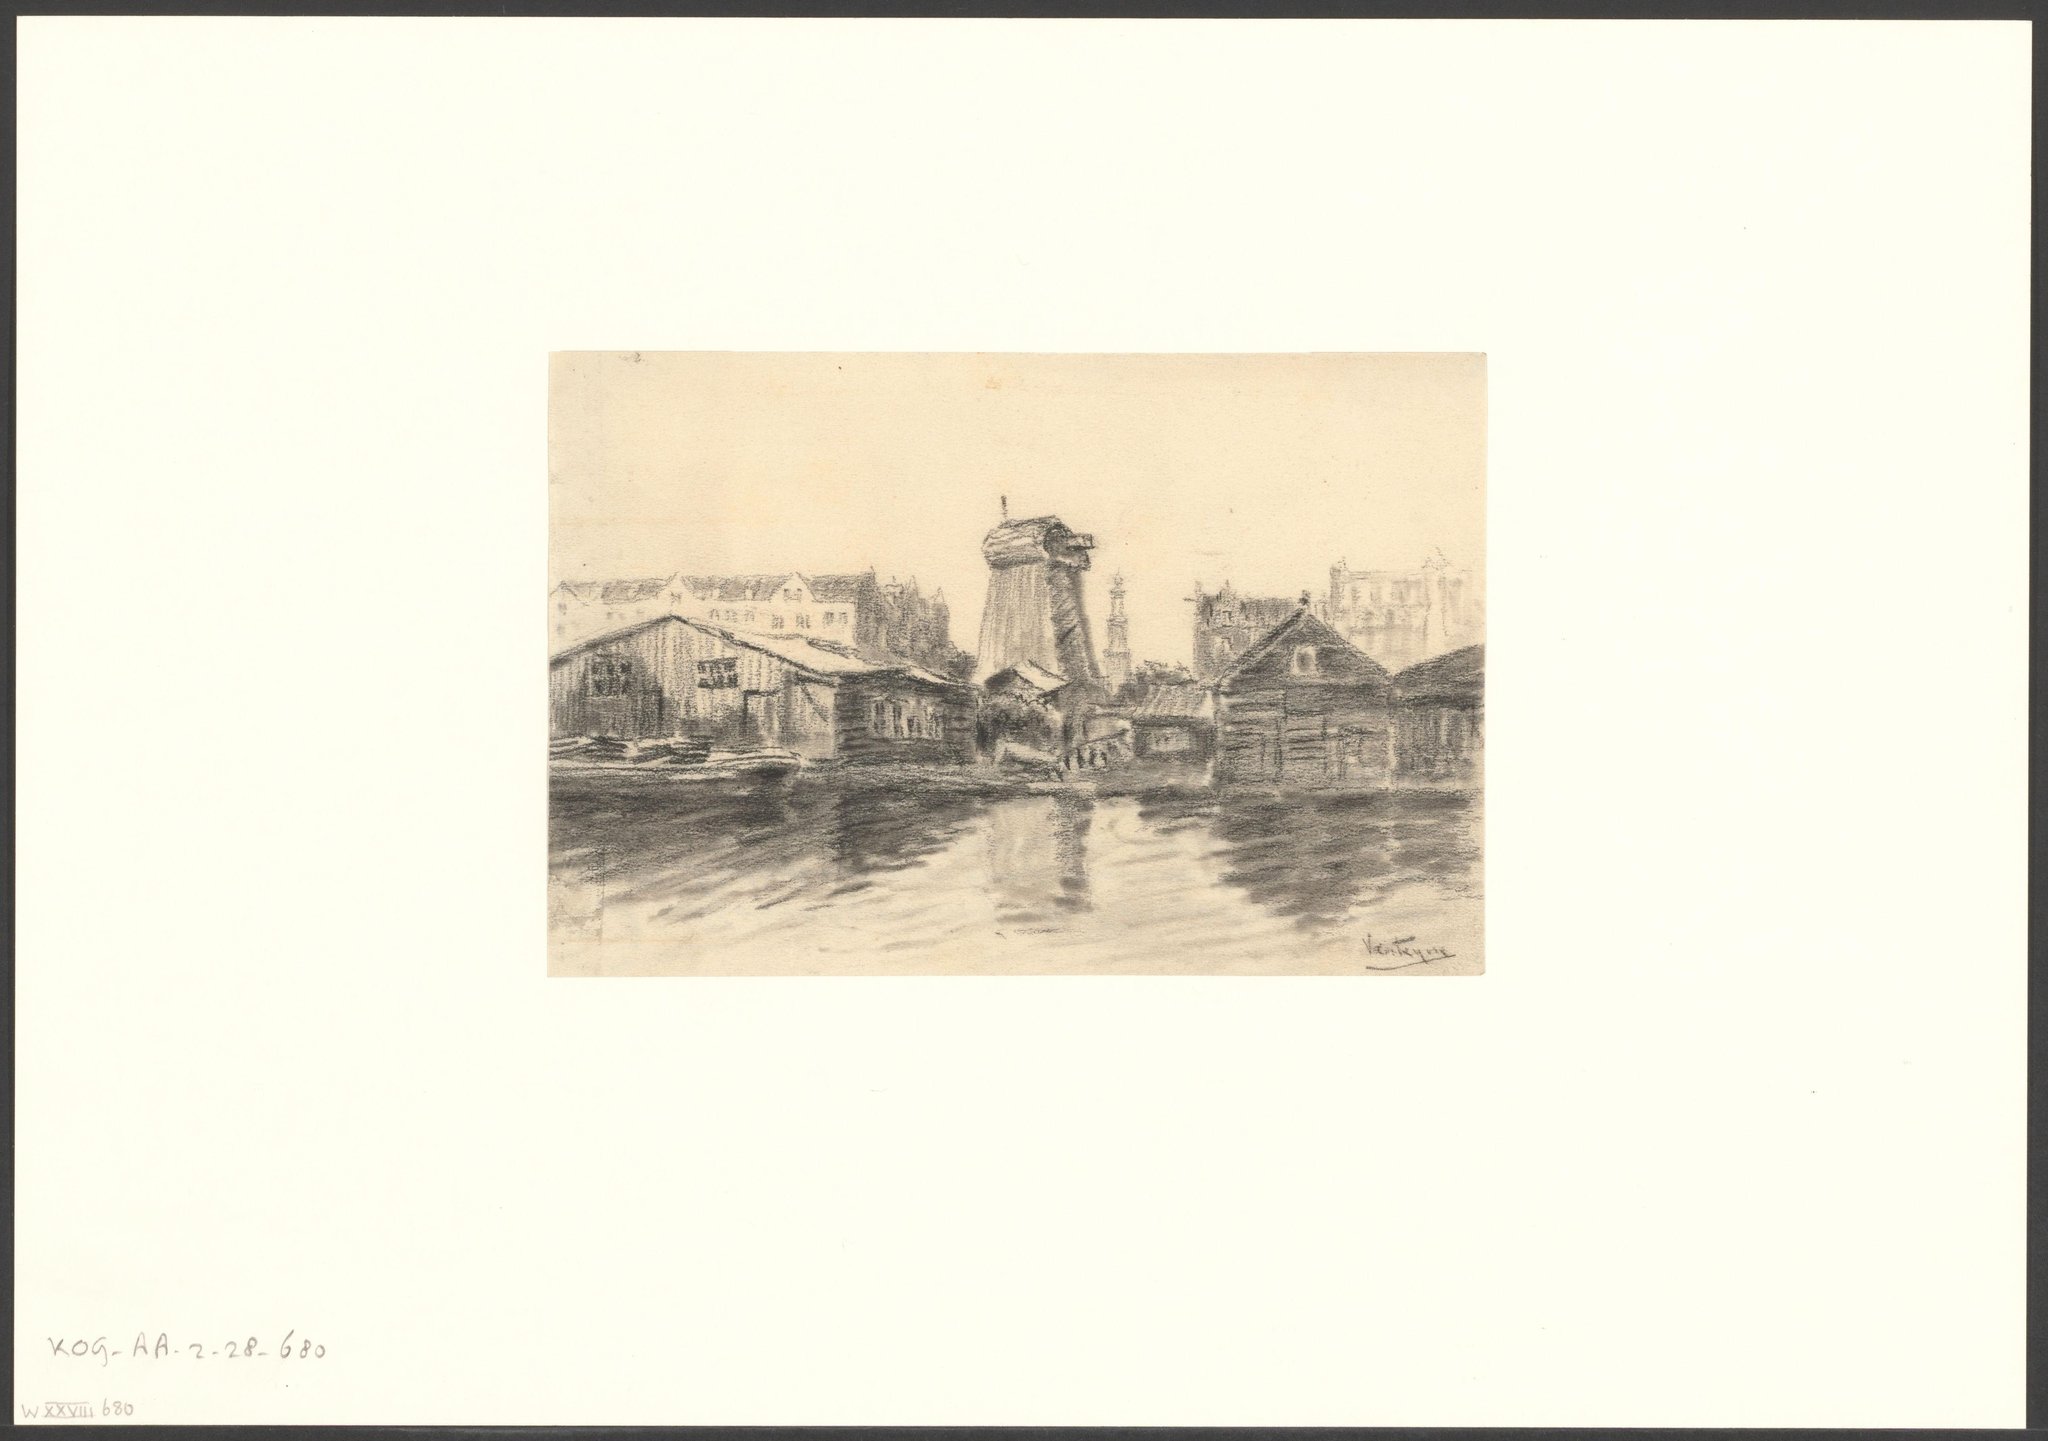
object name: drawing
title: Gezicht vanaf de Buyskade over de Kostverlorenvaart naar molen De Otter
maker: anthonie van teijn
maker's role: draughtsman, painter, print maker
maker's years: 1863-1943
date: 1907-1927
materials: chalk, paper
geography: amsterdam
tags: city-view in general; 'veduta', canal, windmill in landscape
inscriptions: signature: ‘VanTeyne’, collector's mark: Lugt 800a, inscription: ‘Gezicht vanaf de (...) Juli 1927. / VanEck’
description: Tekening binnen de Atlas Van Eck ingedeeld op wijknummer 28.